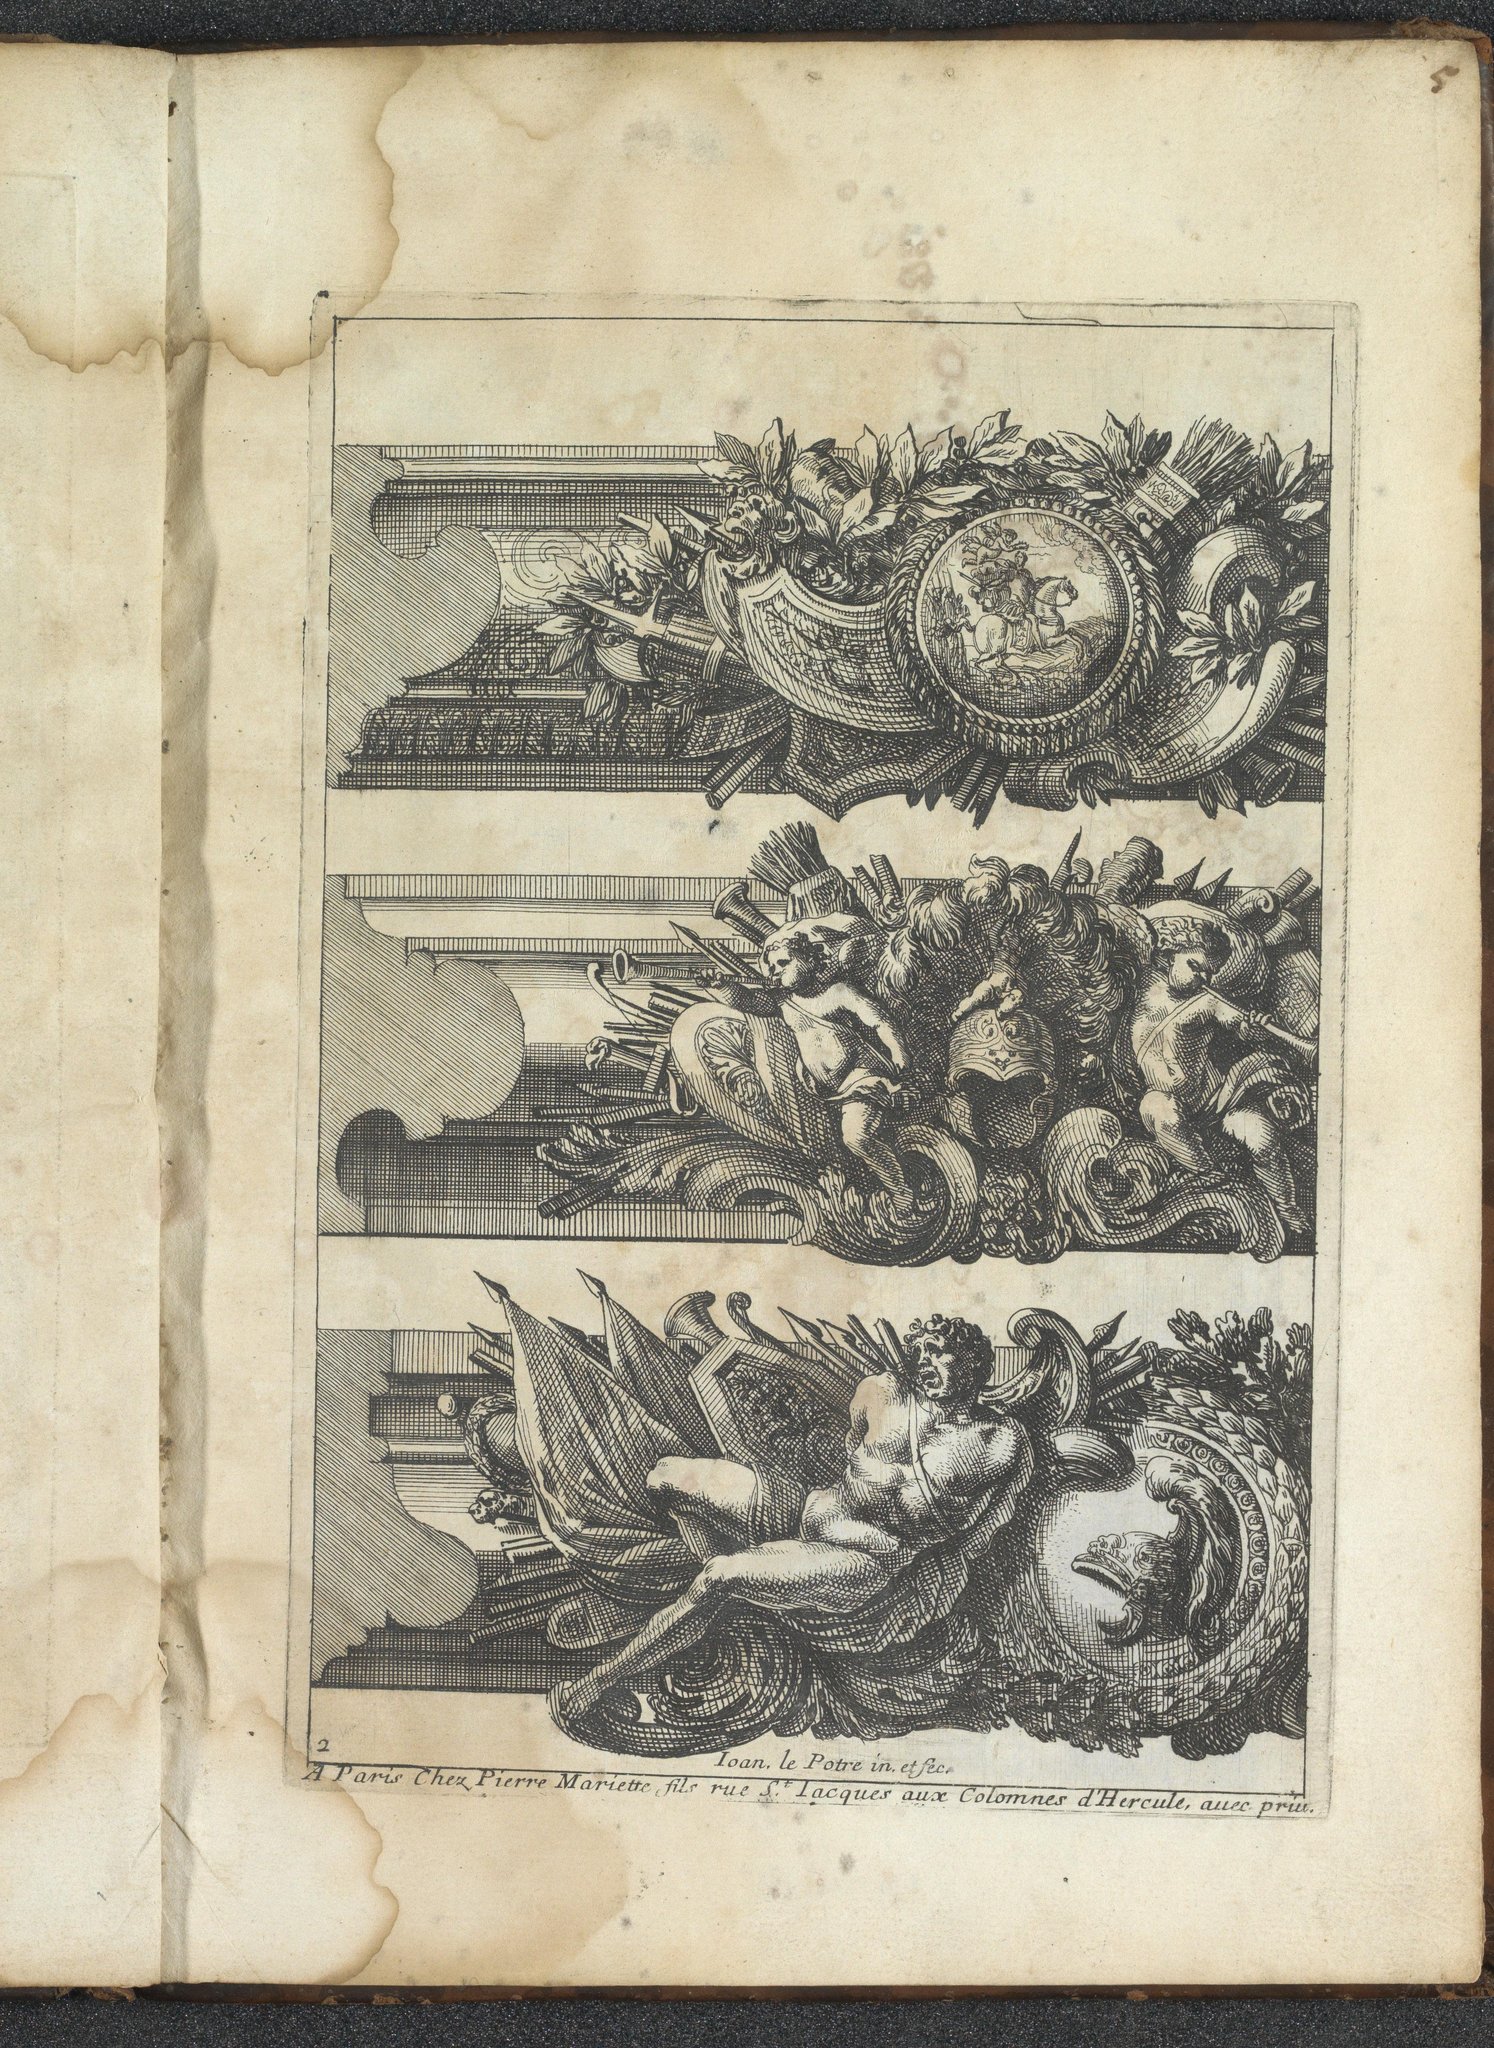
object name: ornament print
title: Bordures de Tableau a la Romaine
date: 1655-1657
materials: paper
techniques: etching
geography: paris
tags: helmet, ornaments ~ art, cupids: 'amores', 'amoretti', 'putti'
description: Drie fragmenten van lijsten met profiel. Op de middelste lijst een helm geflankeerd door putti. Prent maakt deel uit van een album.